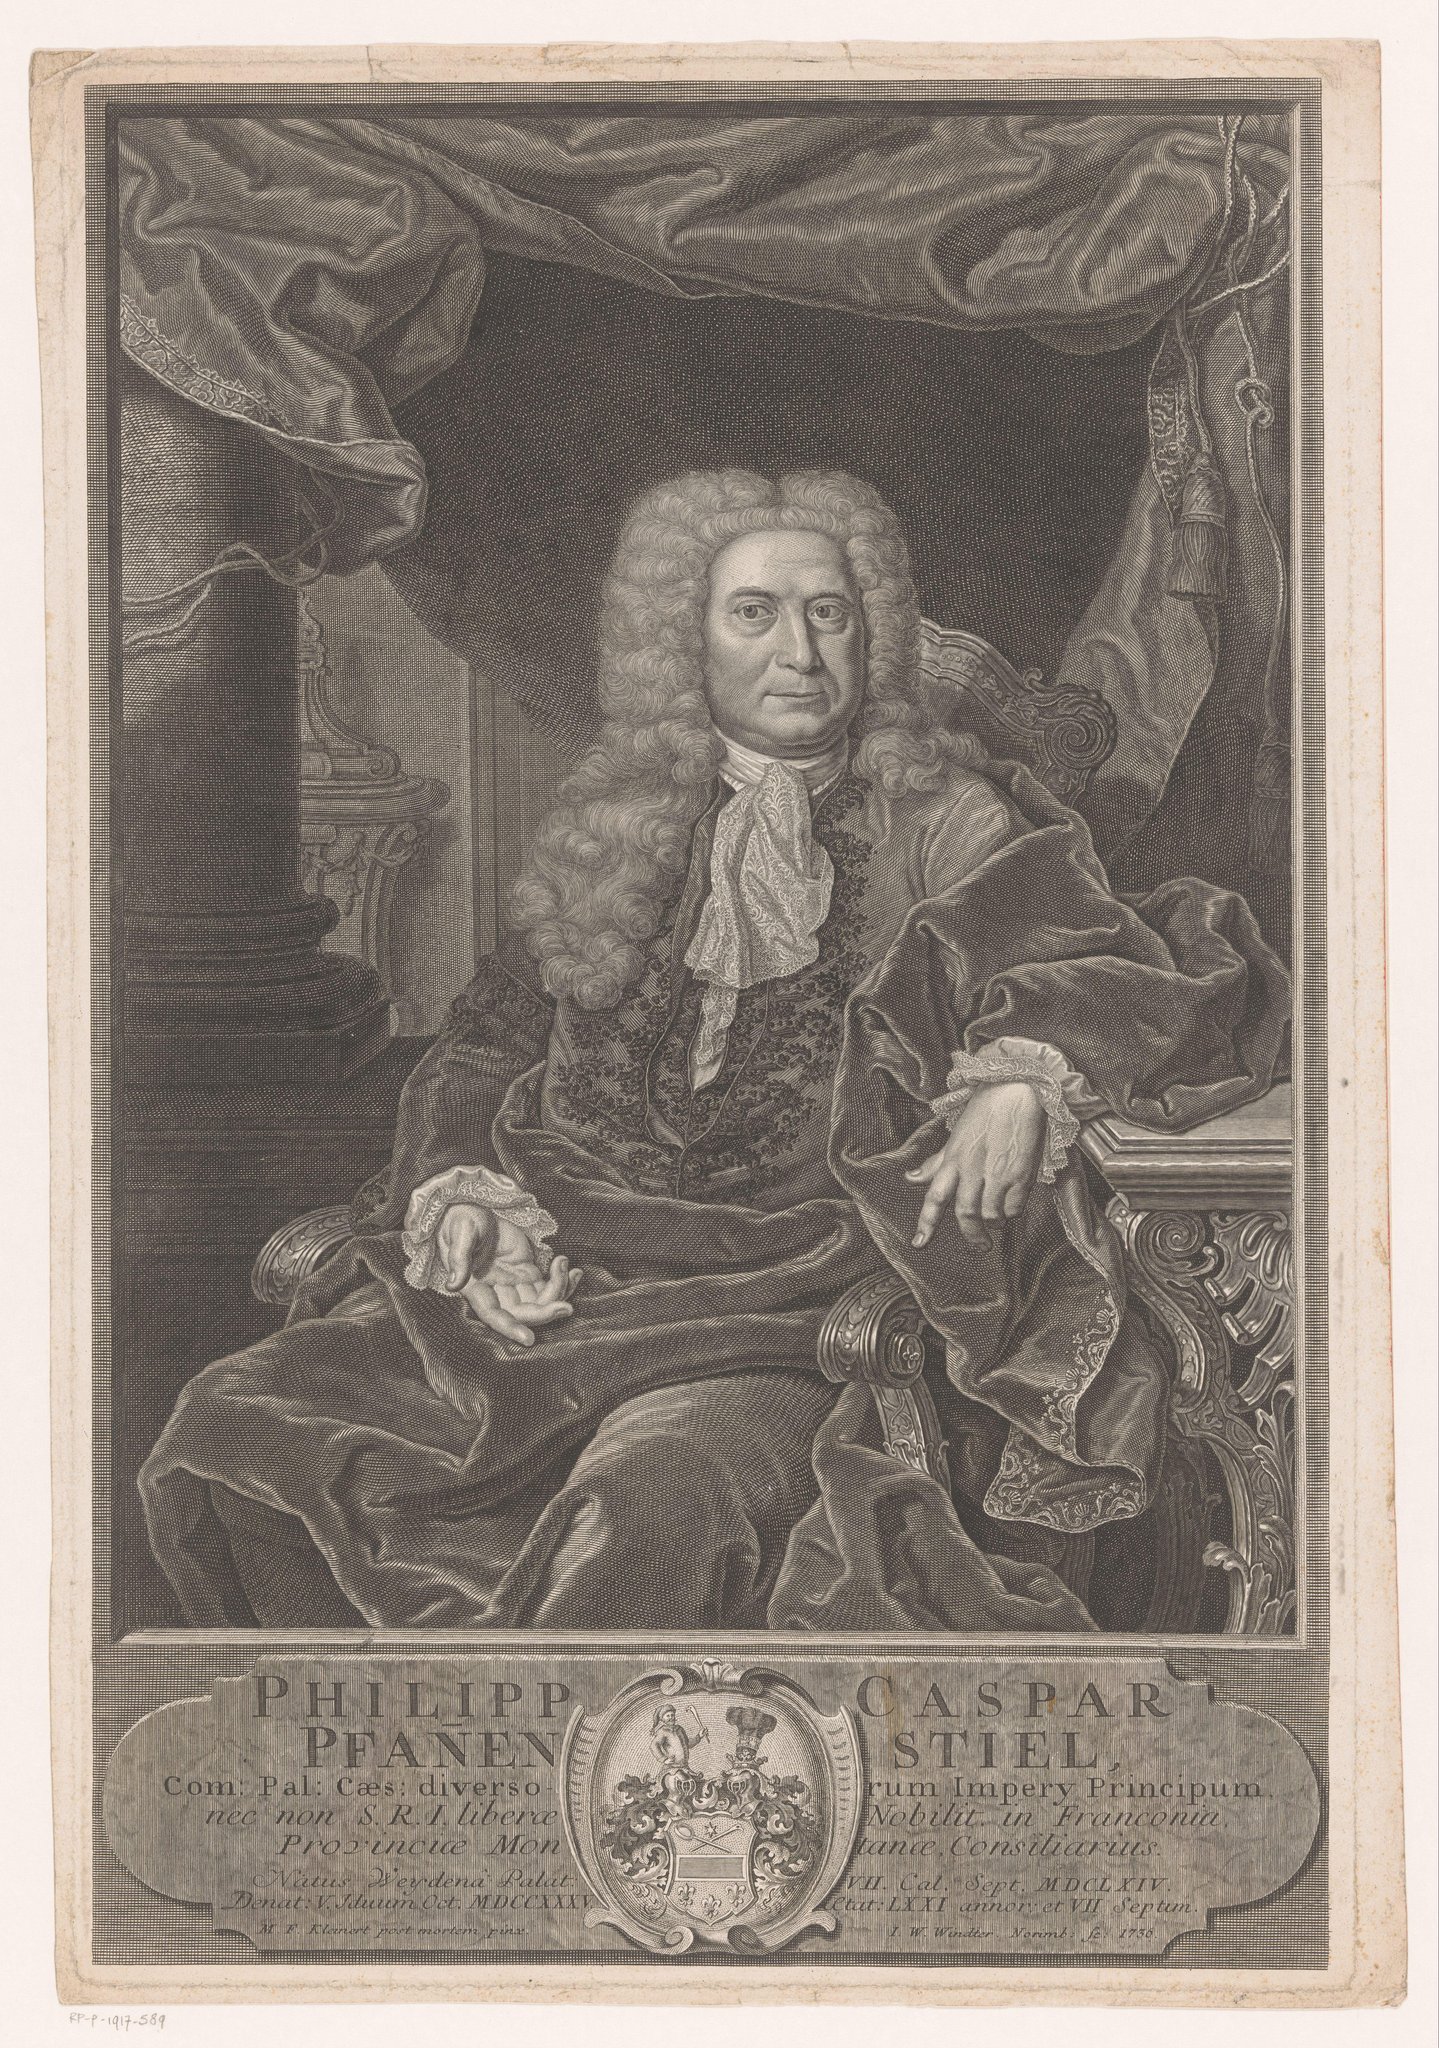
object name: print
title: Portret van Philipp Caspar Pfannenstiel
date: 1736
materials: paper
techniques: engraving, etching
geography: nuremberg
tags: historical persons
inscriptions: collector's mark: Lugt 2228